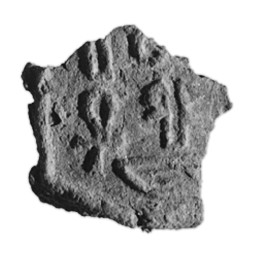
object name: sealing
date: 2030-1640 BCE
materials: clay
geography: egypt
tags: ankh